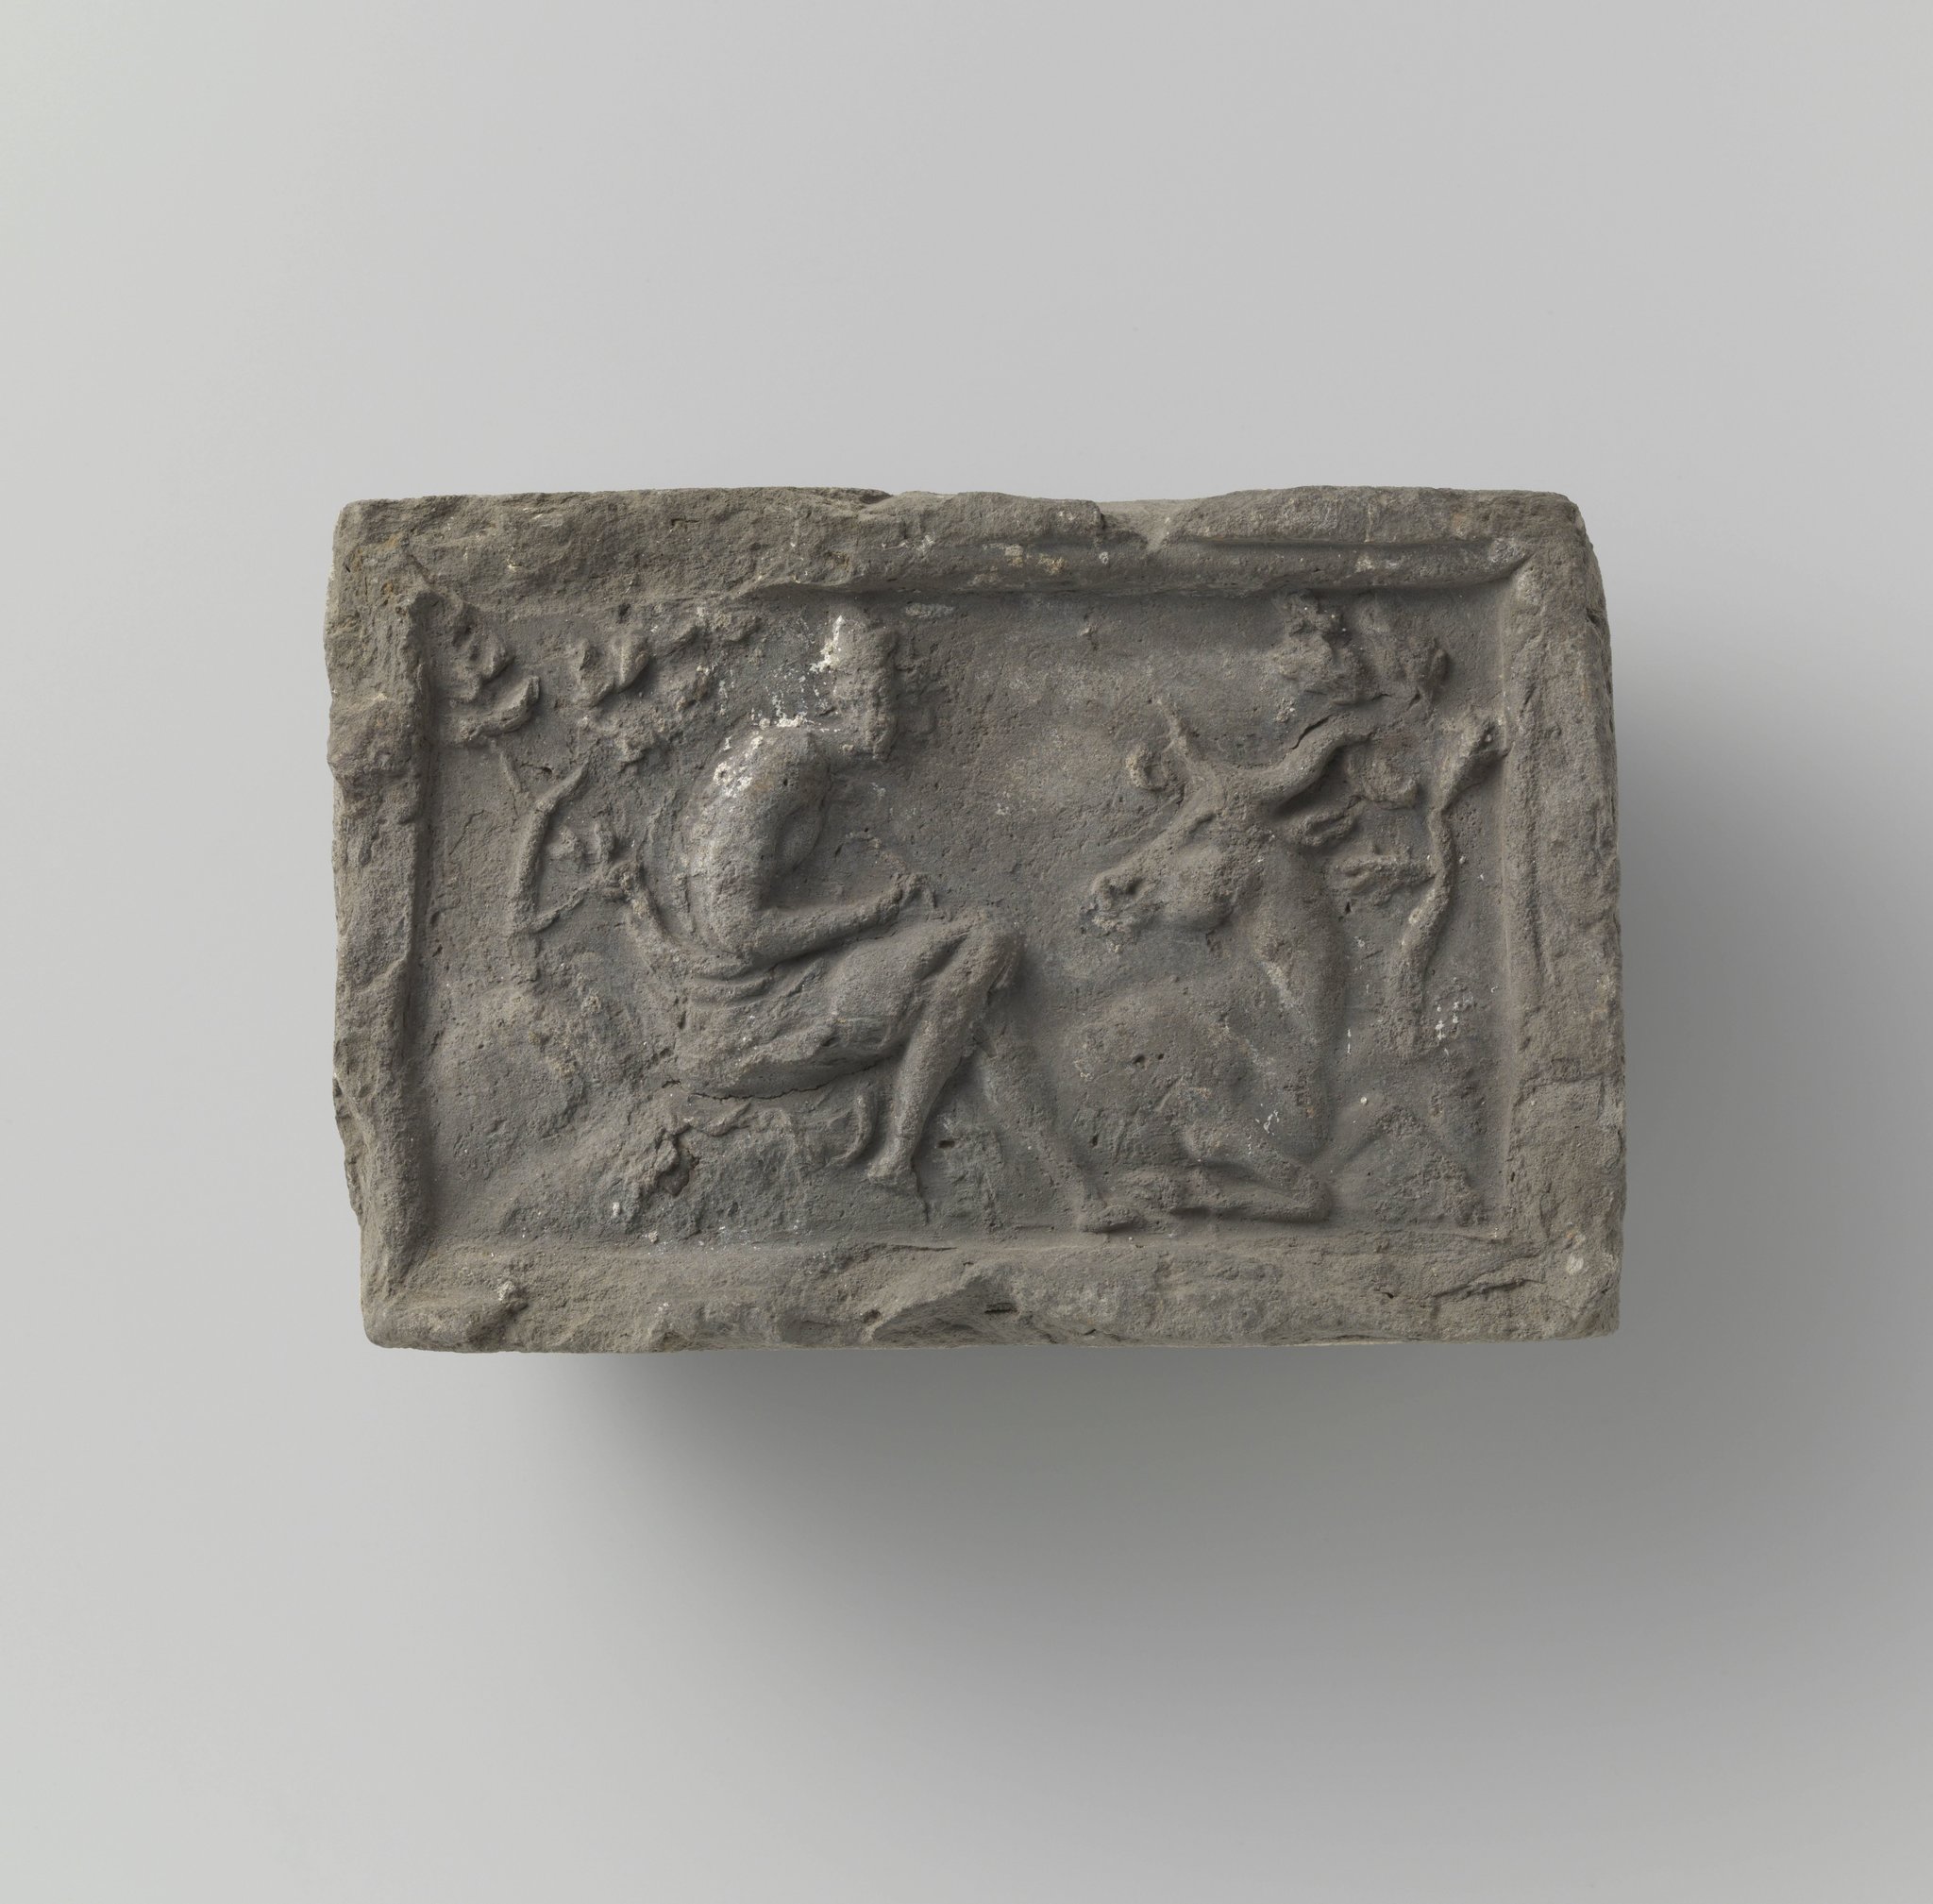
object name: hearthstone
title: Fragment van een haardsteen met afbeelding van de evangelist Marcus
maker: Anonymous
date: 1525-1575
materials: earthenware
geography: antwerp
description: Haardsteen met een afbeelding van de evangelist Lucas, met een schrijfstif in de hand zittend in een landschap. Hij wordt vergezeld door een liggende os.